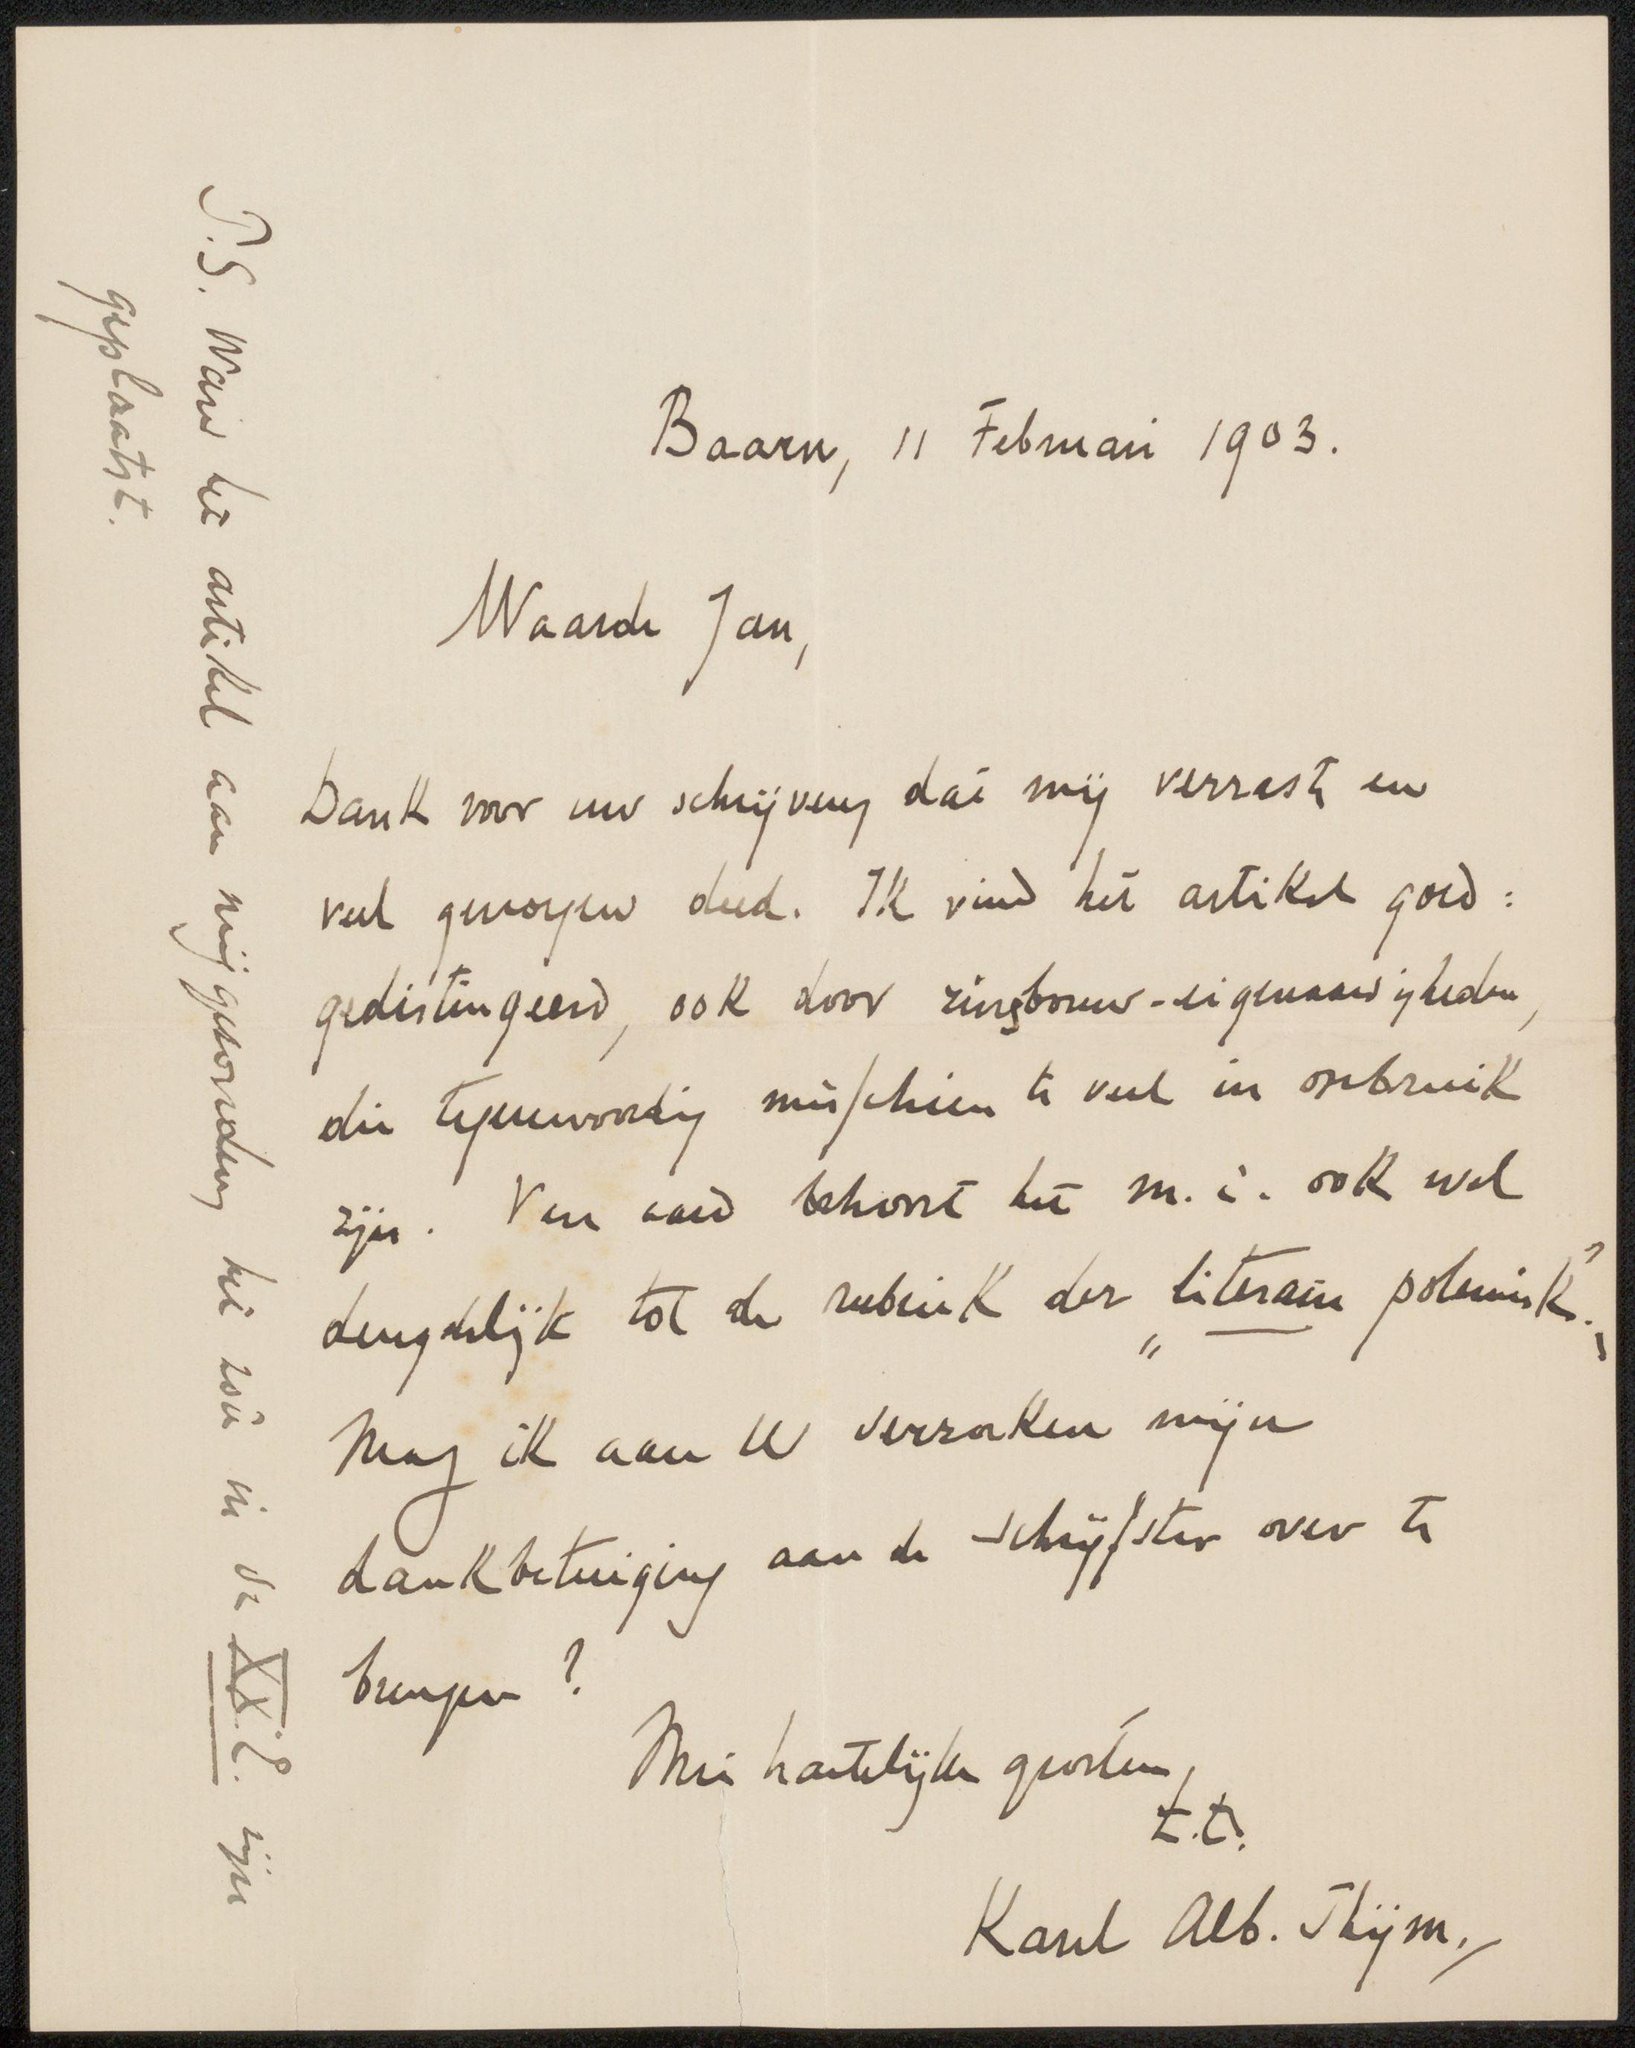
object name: letter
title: Brief aan Jan Veth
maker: karel johan lodewijk alberdingk thijm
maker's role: criticus, prozaschrijver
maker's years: 1864-1952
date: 1903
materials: ink, paper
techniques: pen, writing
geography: baarn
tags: dordrecht, amsterdam, painter, draughtsman, designer, jan veth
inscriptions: collector's mark: ‘RPK’